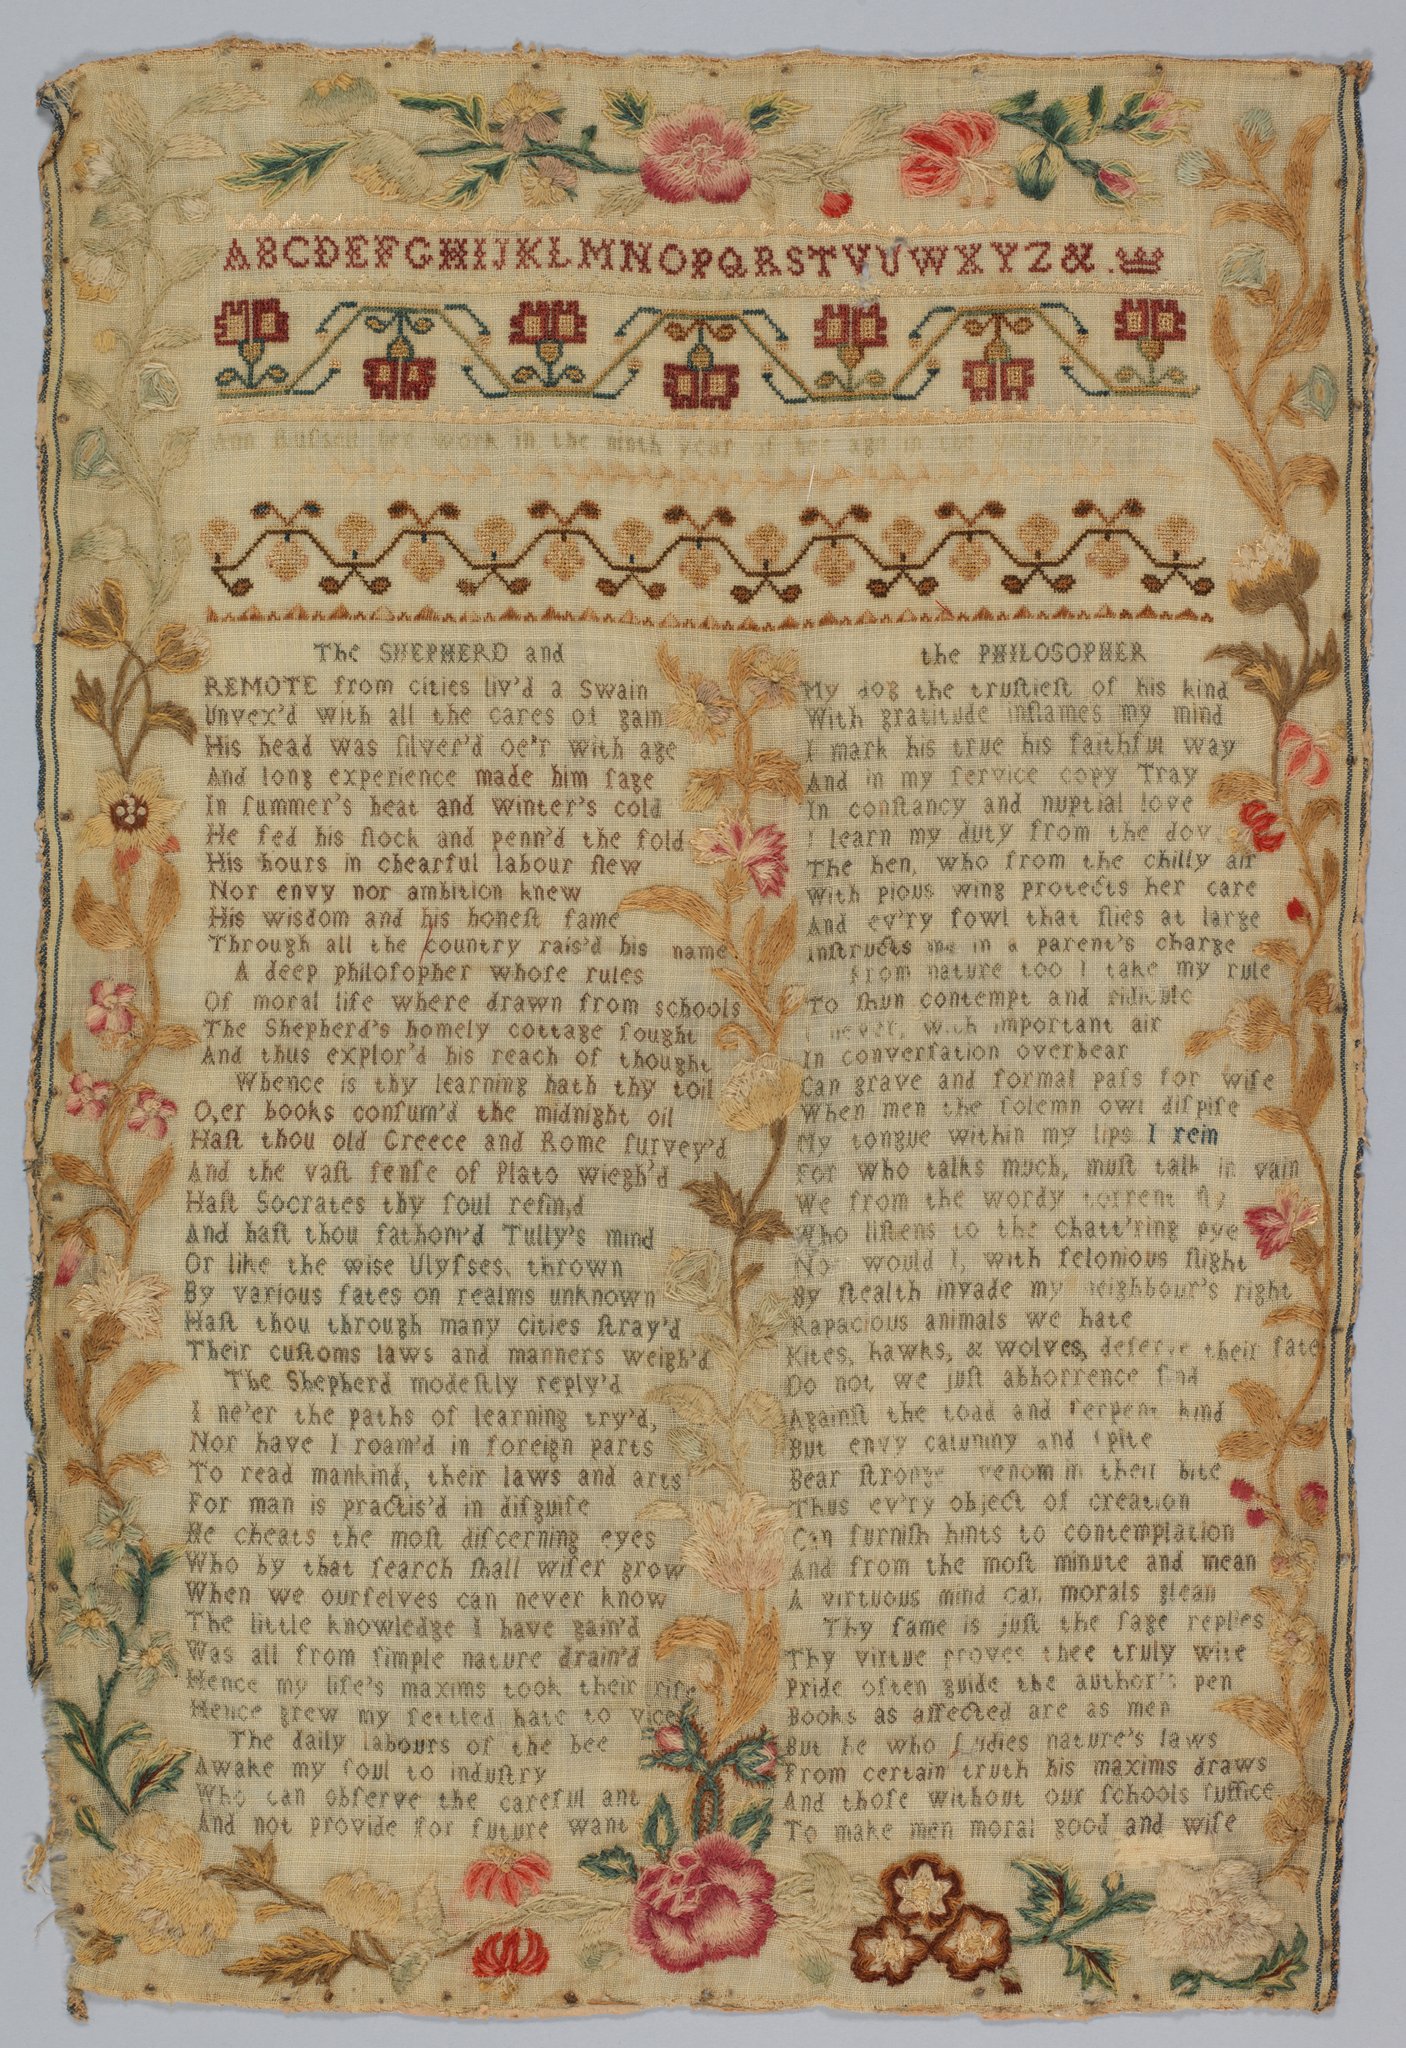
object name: sampler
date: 1779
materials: canvas, silk, wool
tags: flowers